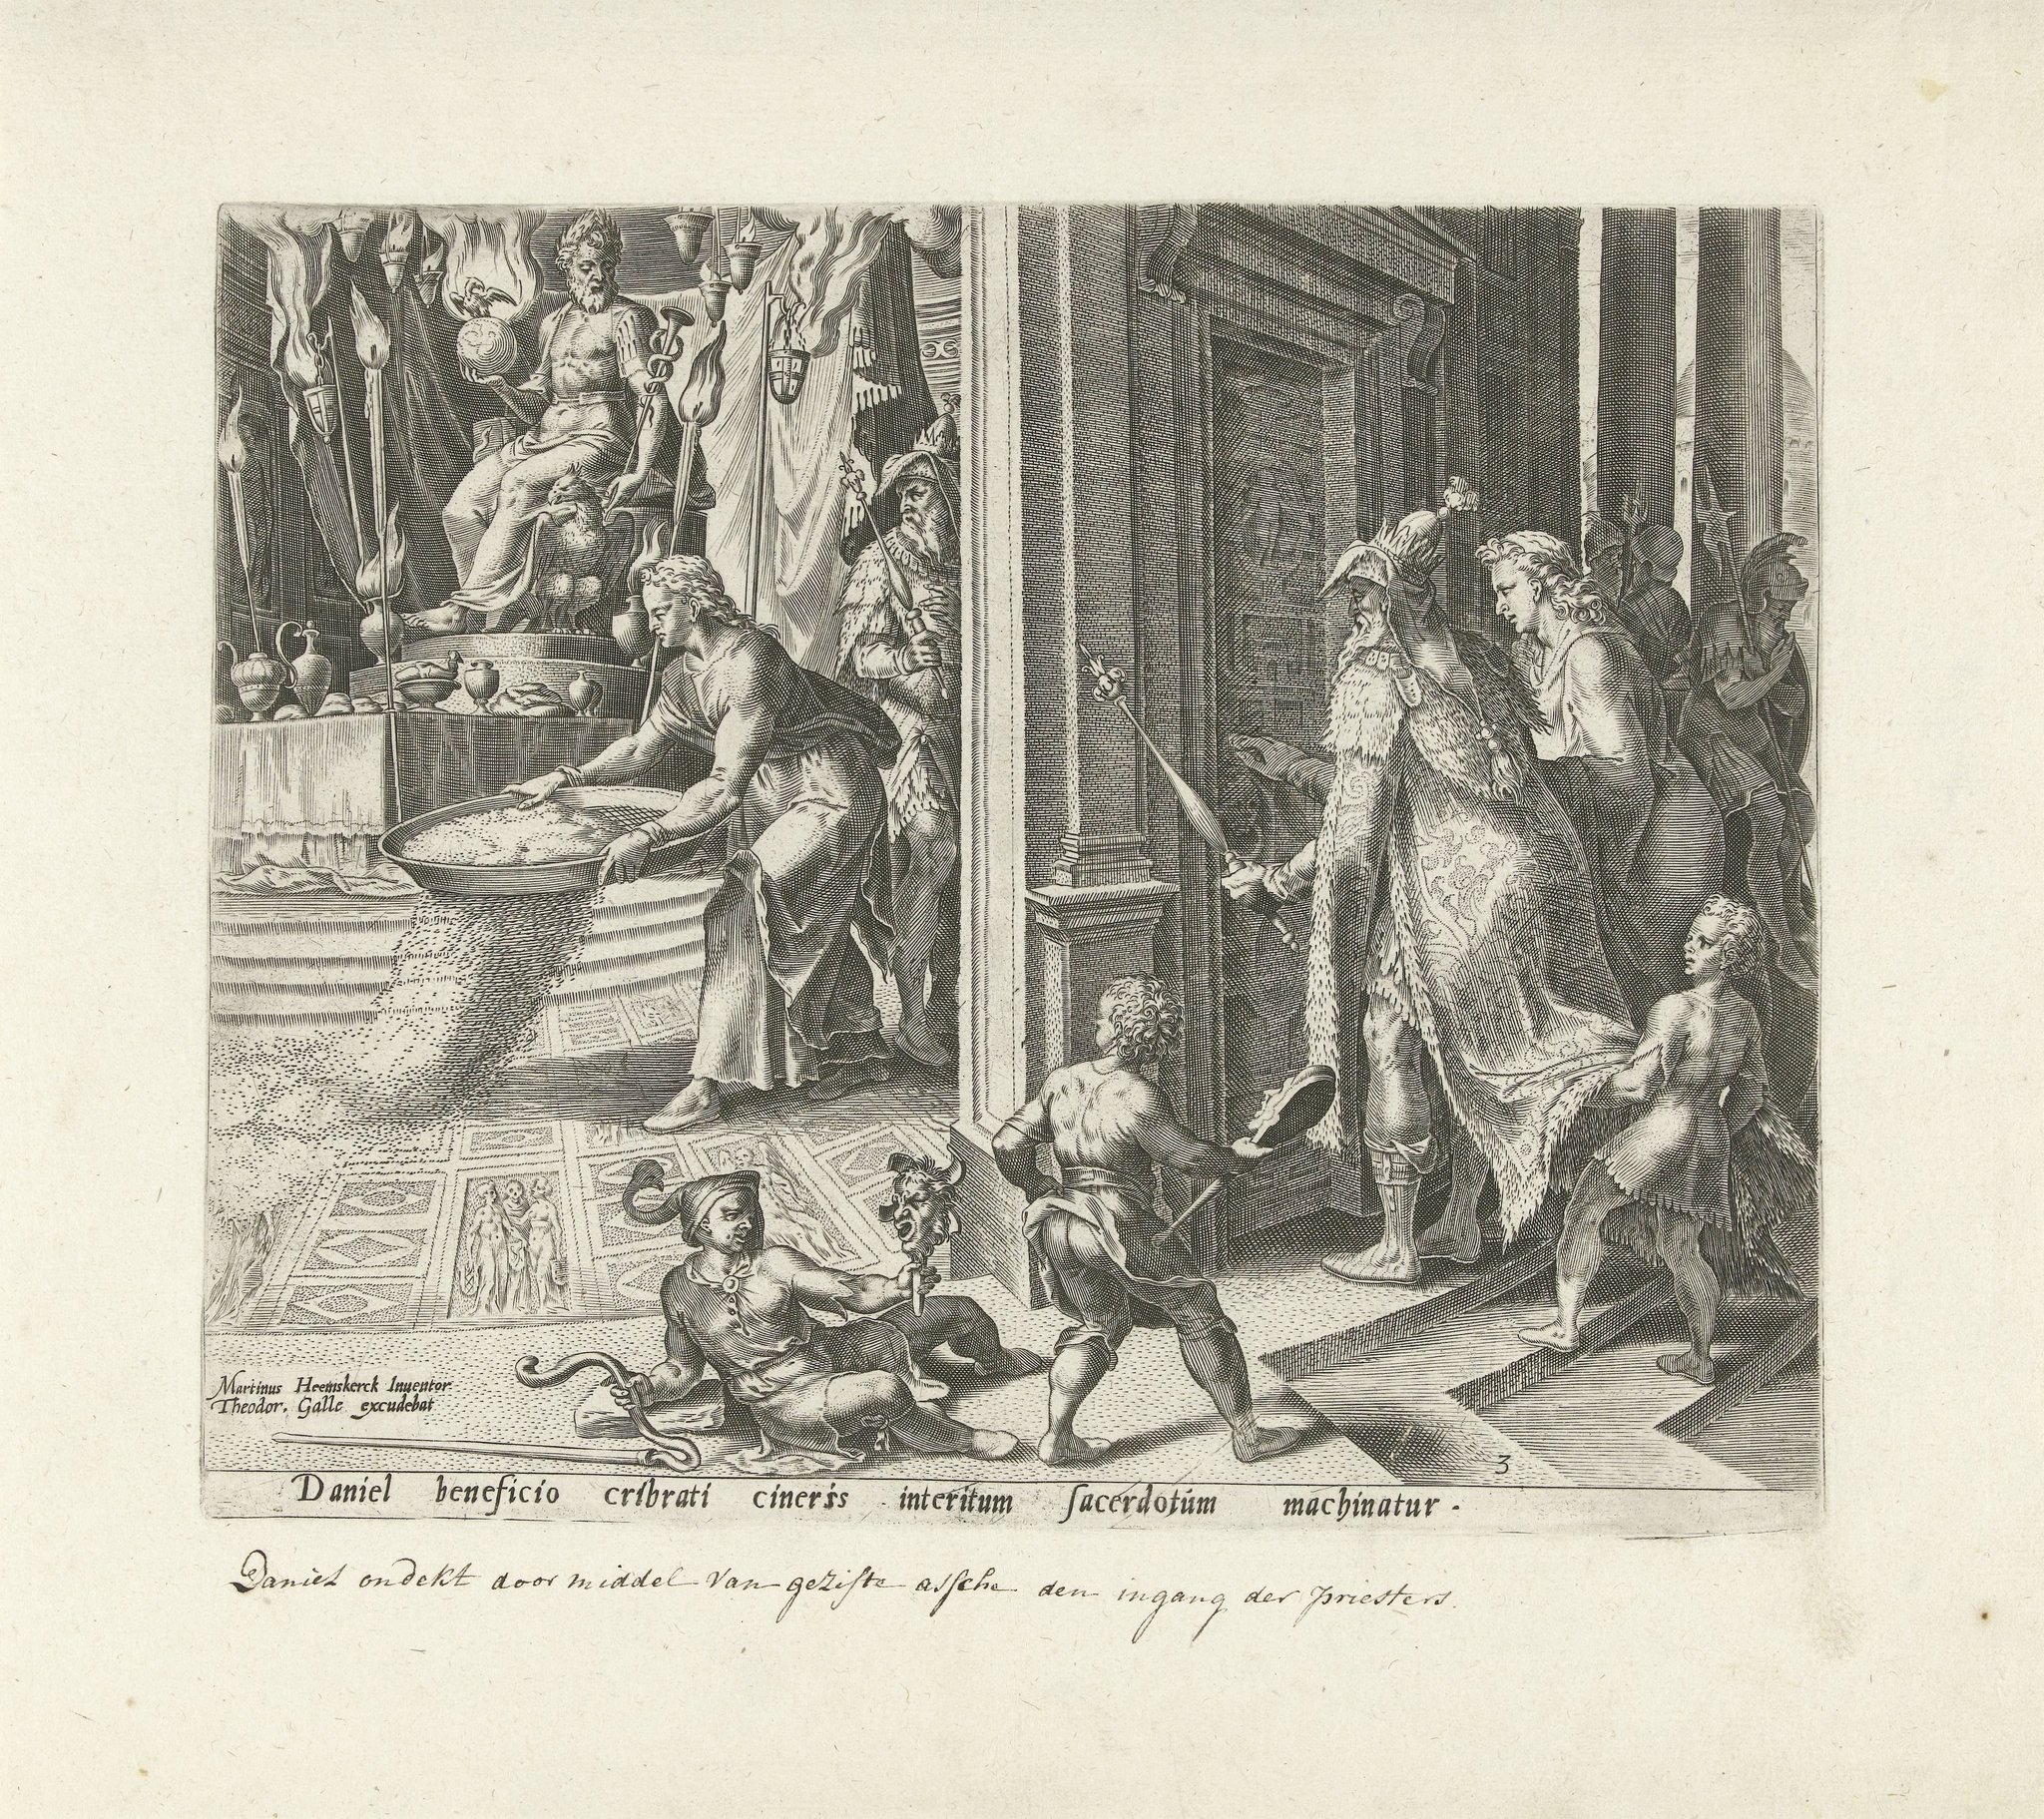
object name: print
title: Geschiedenis van Daniël, Bel en de draak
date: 1601-1633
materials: paper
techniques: engraving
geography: antwerp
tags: king cyrus sets food before the image of bel; daniel and his servants strew ashes on the floor of the temple, the door of the temple is sealed ~ story of the image of bel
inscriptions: inscription: ‘Daniel ontdekt door middel van ...’, collector's mark: Lugt 2228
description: Om te bewijzen dat niet het beeld van de god Bel het eten nuttigt, maar de priesters, strooit Daniël as uit op de vloer van de tempel. Koning Cyrus laat de deur van de tempel verzegelen, zodat niemand ongemerkt binnen kan komen.